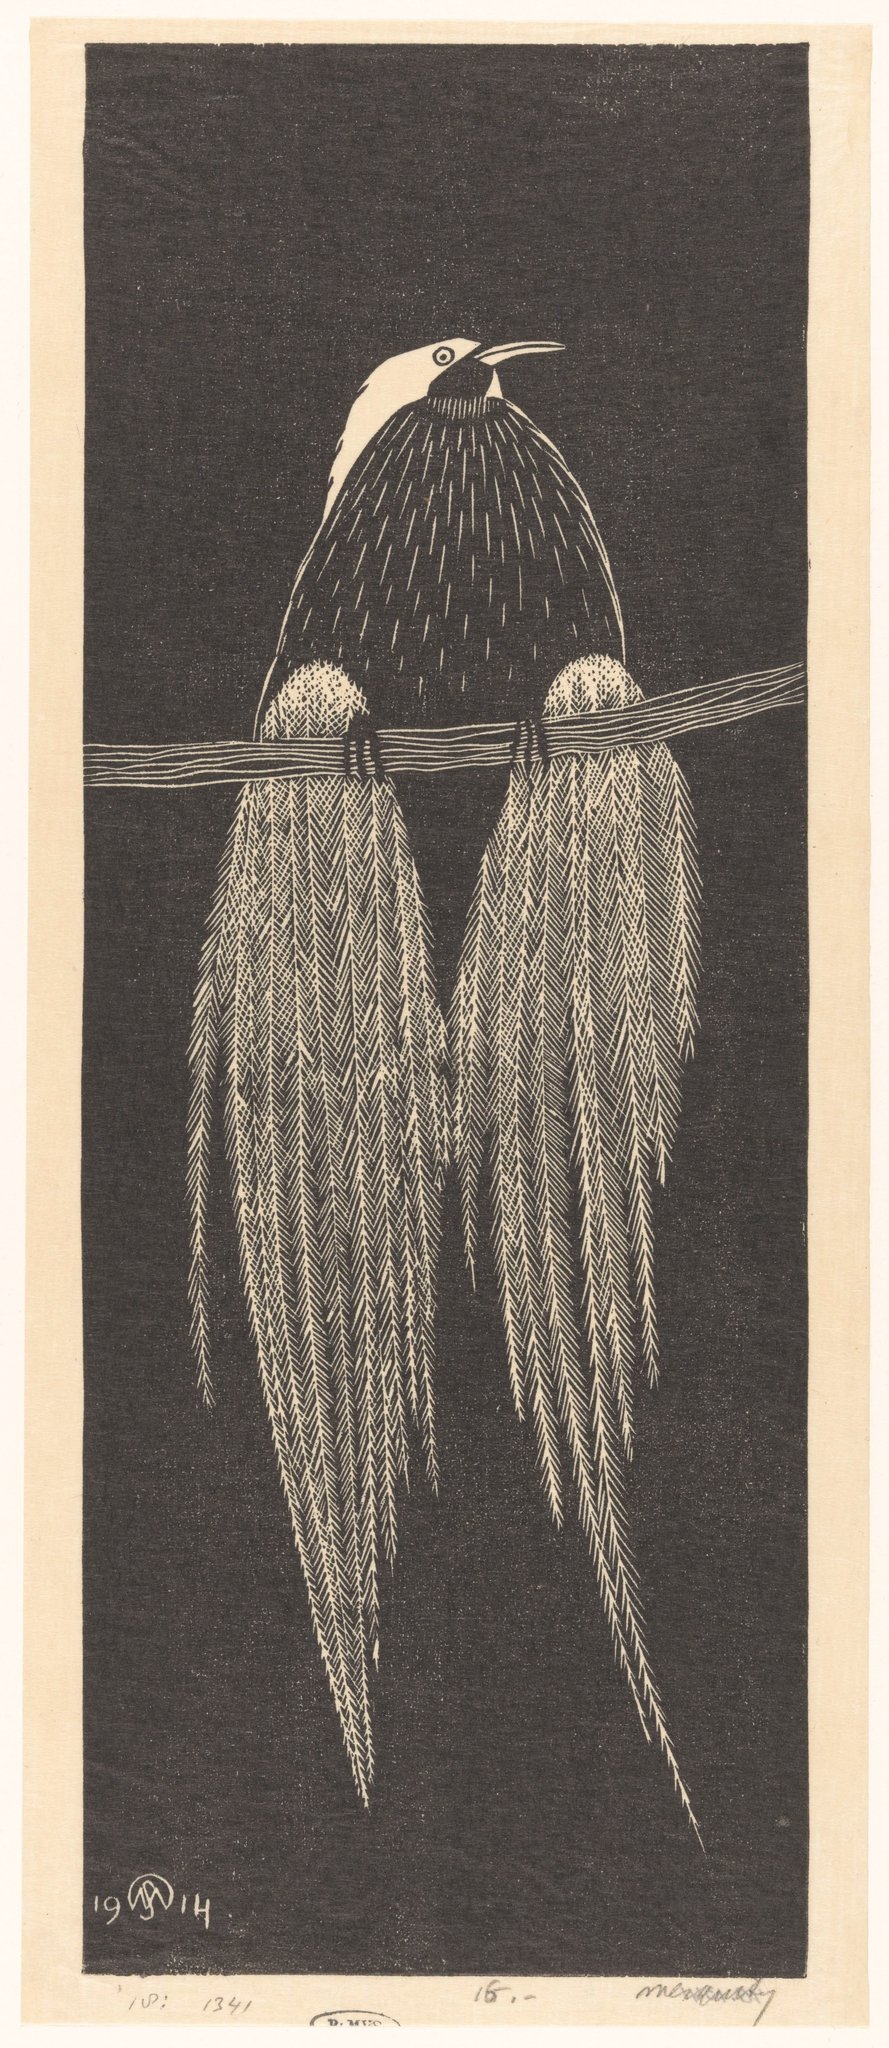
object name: print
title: Paradijsvogel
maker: samuel jessurun de mesquita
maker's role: draughtsman, print maker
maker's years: 1868-1944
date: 1914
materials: paper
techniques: woodcut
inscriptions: signature: ‘mesquita’, monogram and date: ‘19 SM 14’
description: Hier heeft Jessurun de Mesquita het streven naar het weergeven van een echt dier bijna helemaal losgelaten. Wat overblijft zijn patronen binnen de omtrekken van een paradijsvogel die lijkt te zijn versmolten met de achtergrond. Wat voornamelijk telt, is het decoratieve karakter. De fijne witte lijnen in de staart van de vogel doen denken aan de manier waarop Escher de vacht van zijn ‘Witte kat’ uitvoerde.